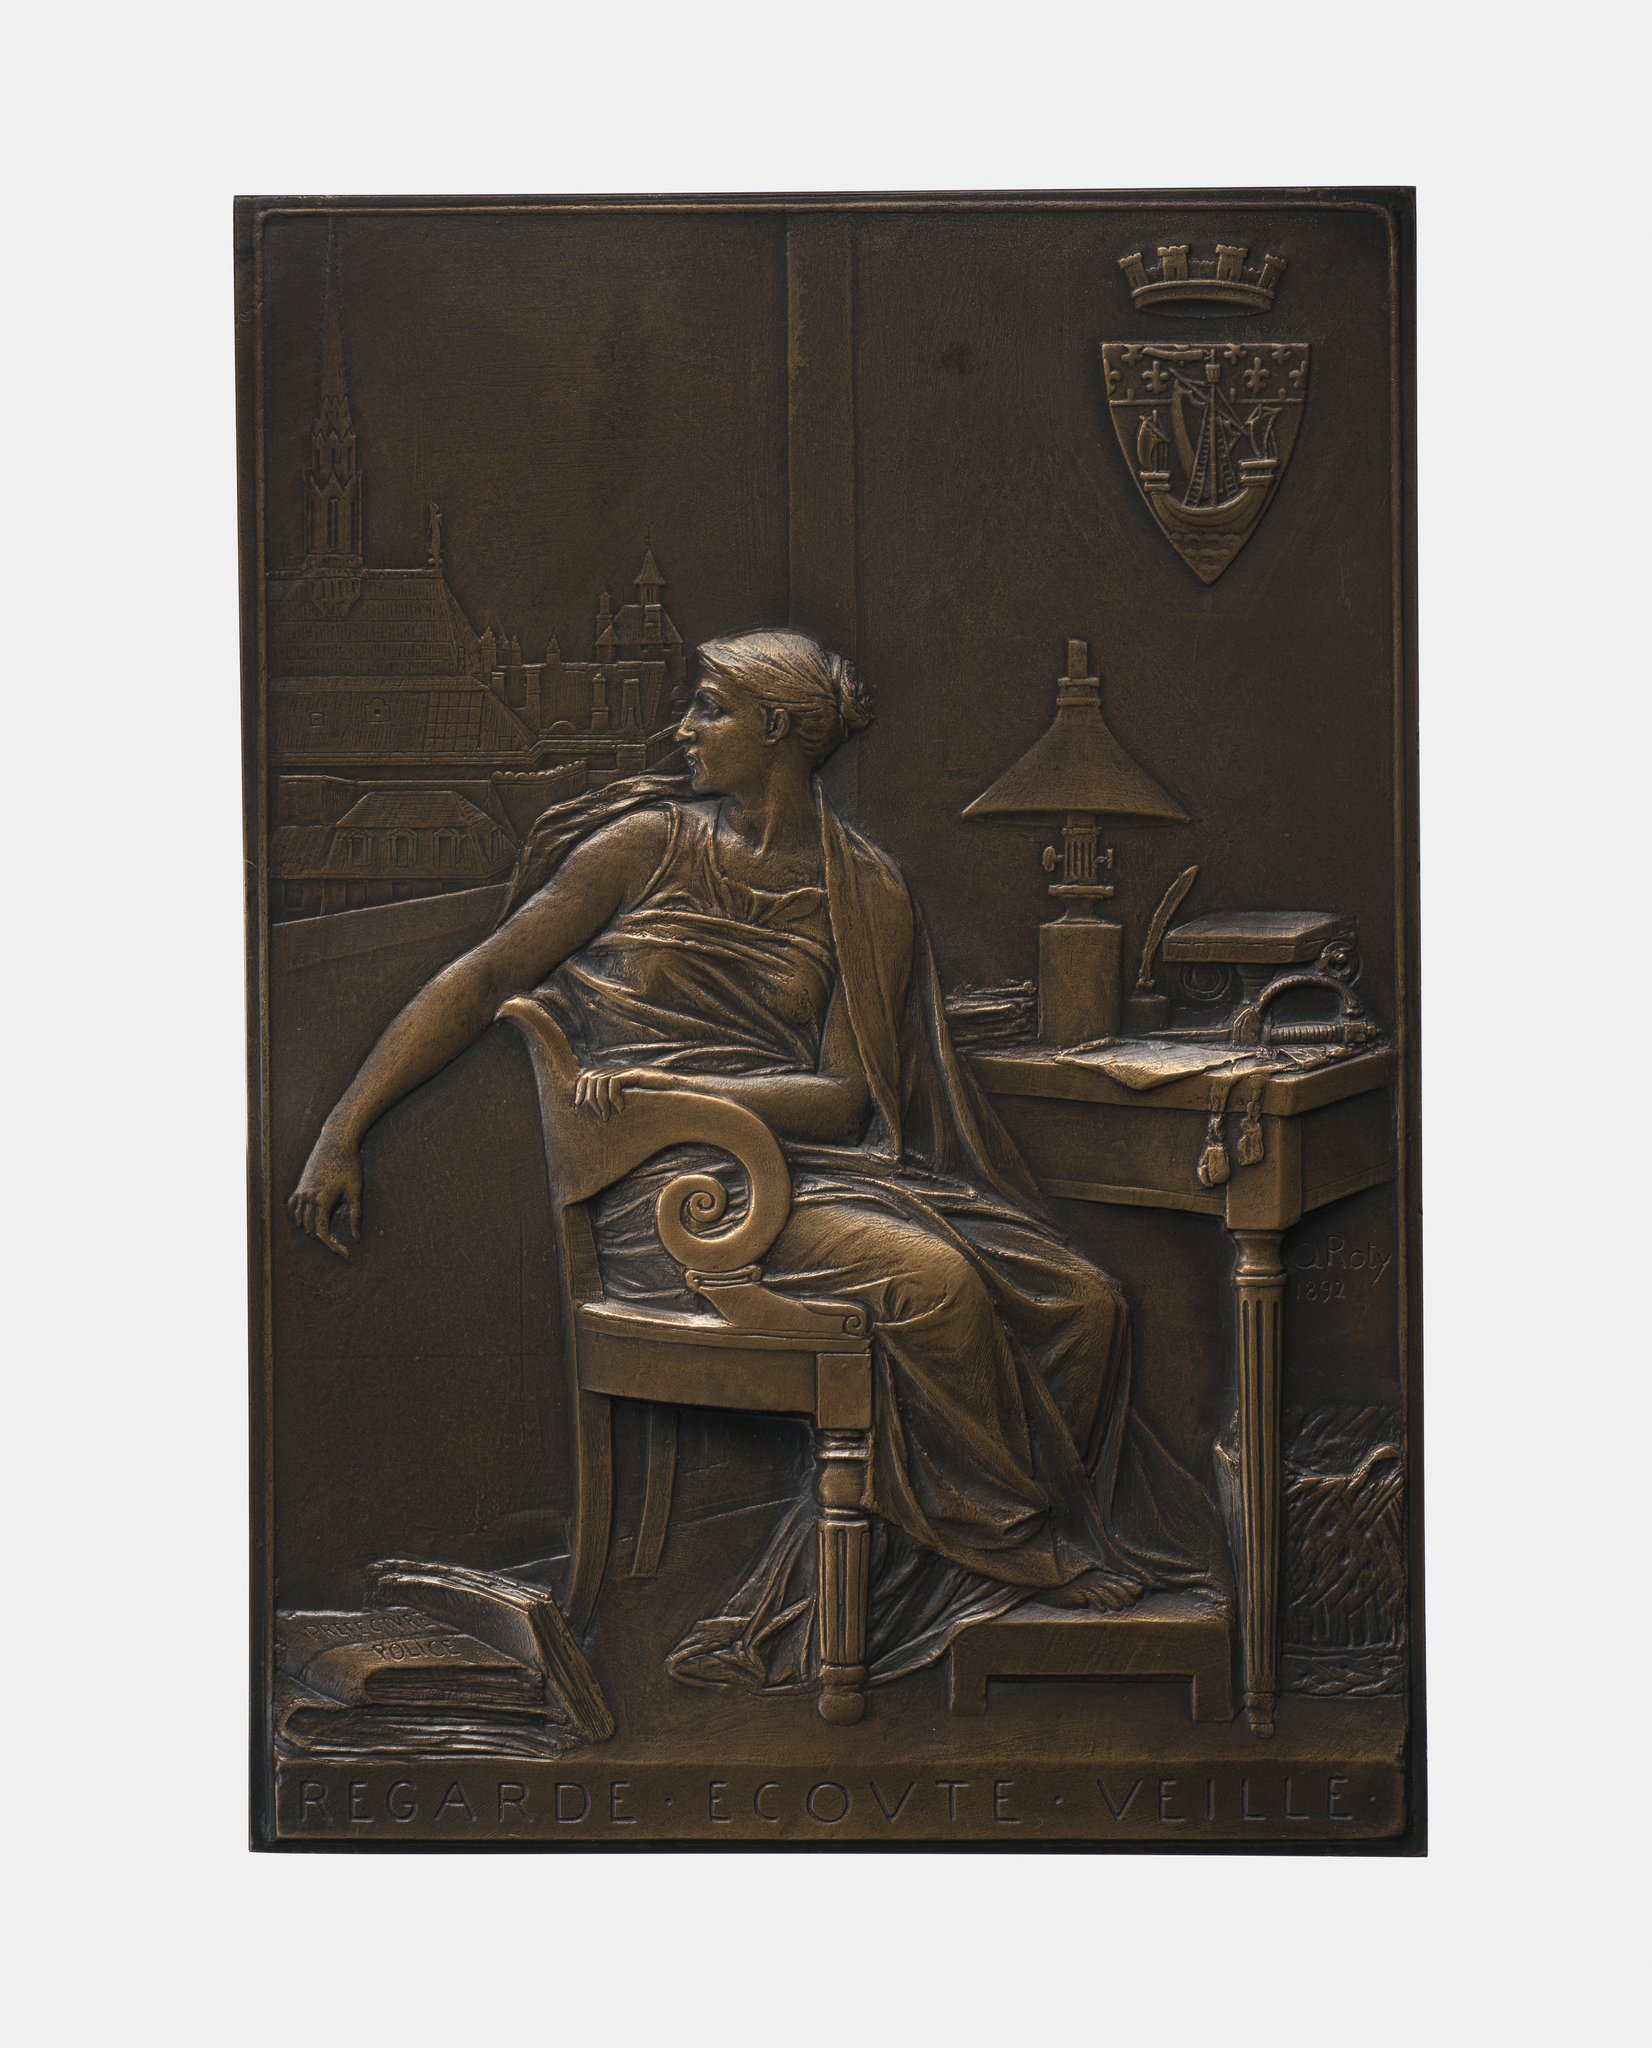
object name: plaquette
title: In Honor of Henry Lozé, Prefect of Police of Paris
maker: louis-oscar roty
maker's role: artist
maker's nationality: french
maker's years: 1846-1911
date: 1892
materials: bronze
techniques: silvered, struck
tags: women,desks